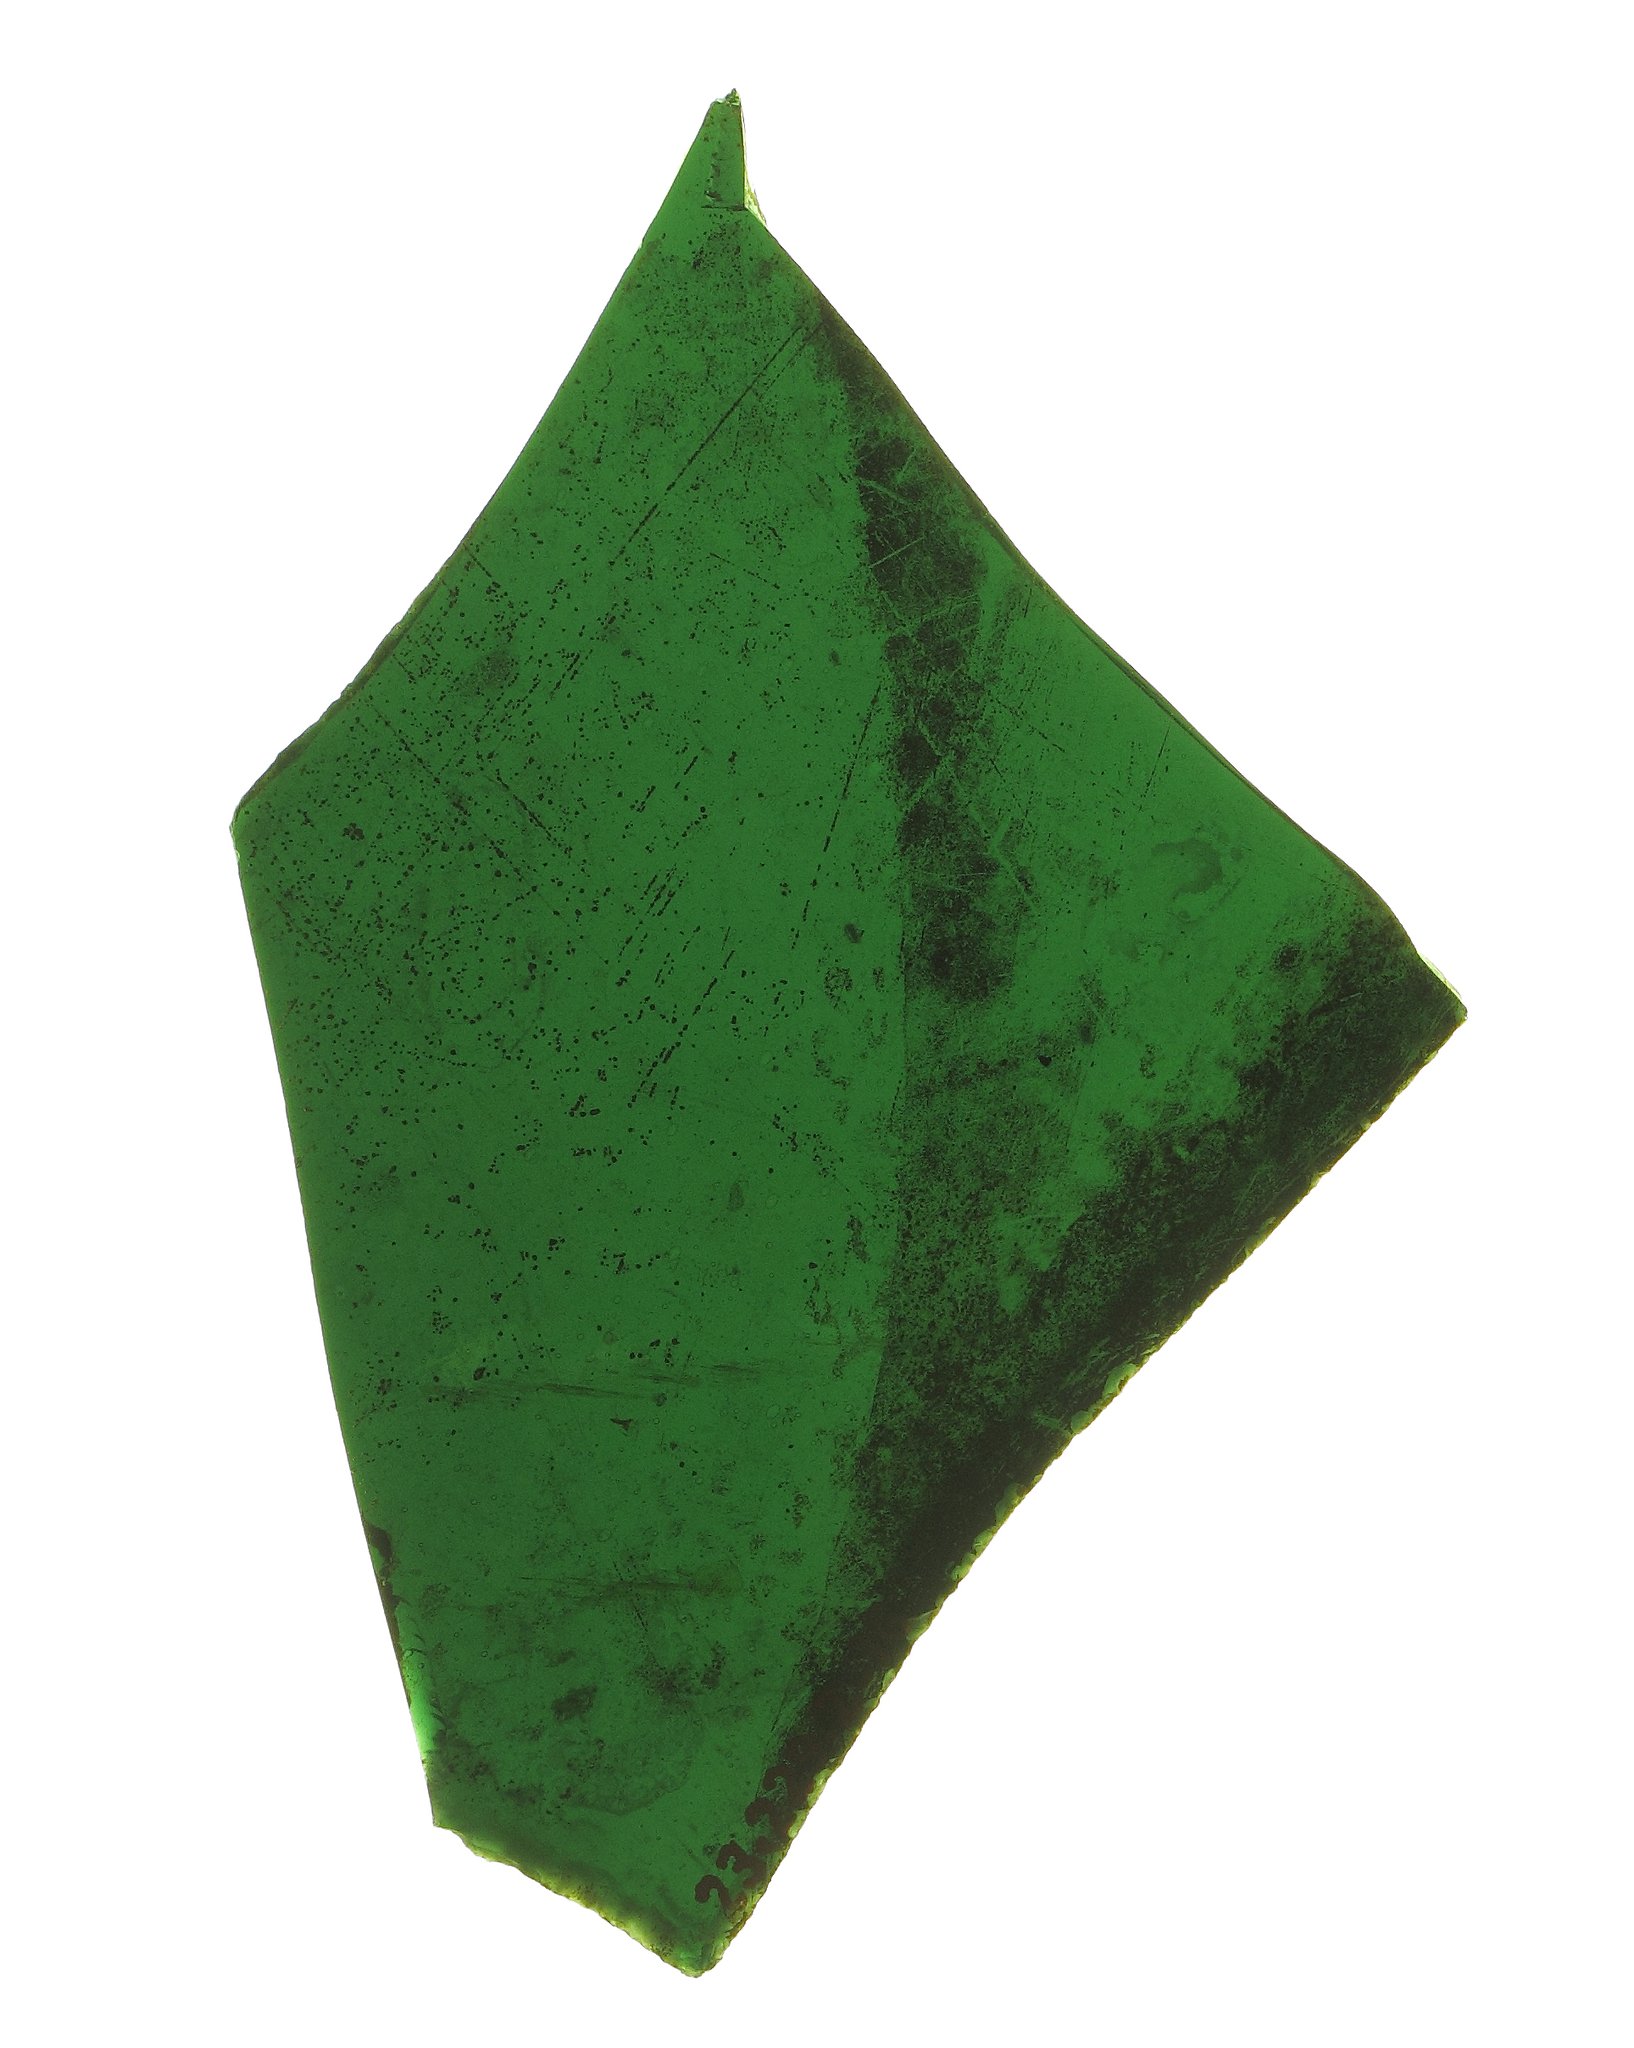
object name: fragment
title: Glass Fragment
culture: british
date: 1501-1600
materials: glass, metal